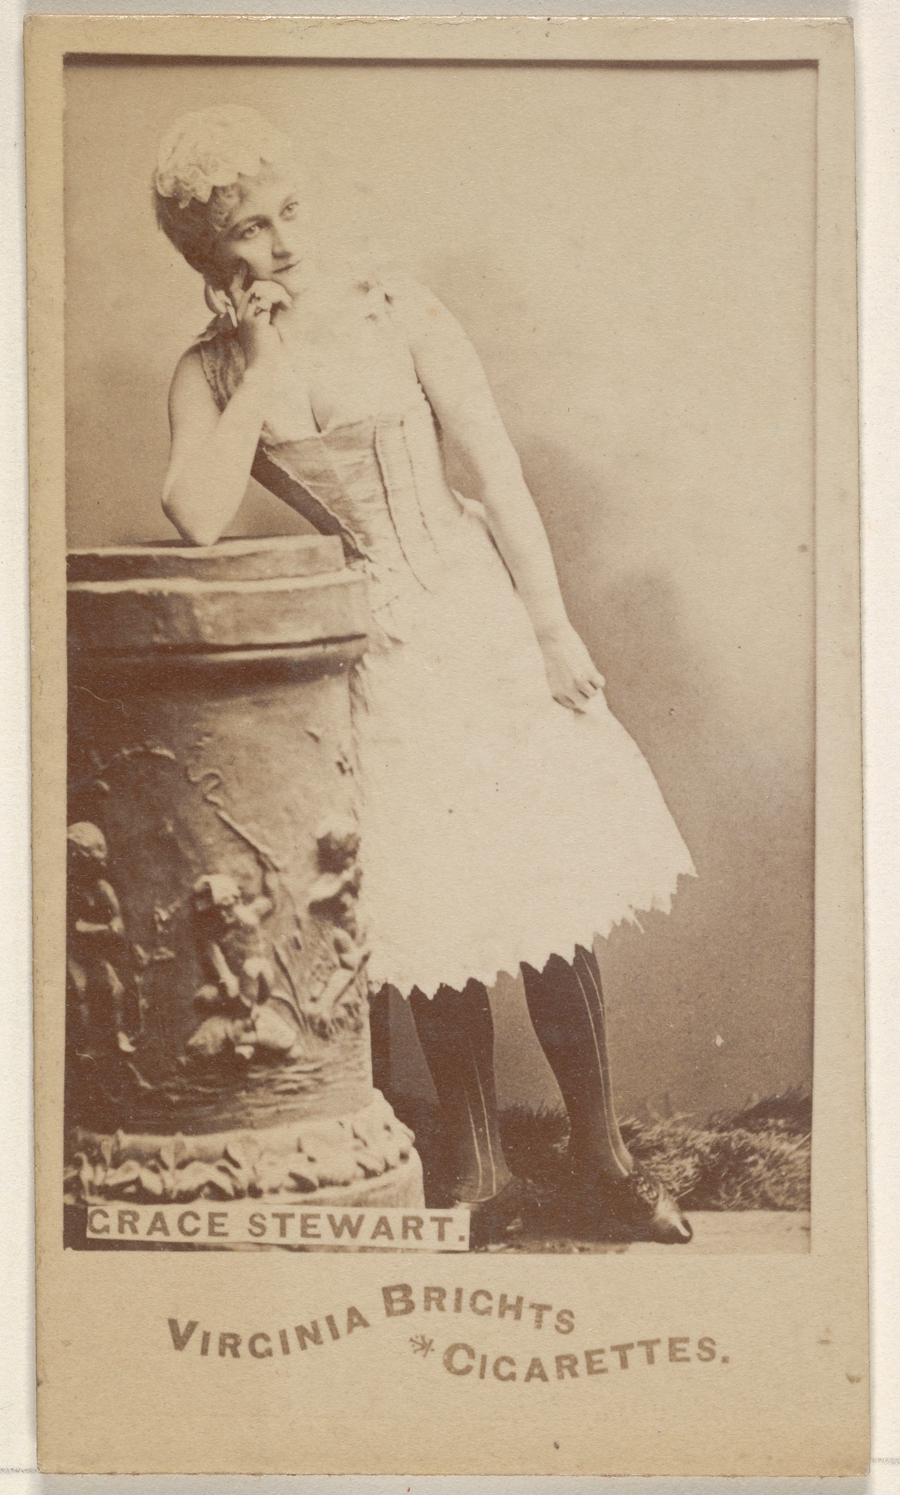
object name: photograph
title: Grace Stewart, from the Actors and Actresses series (N45, Type 6) for Virginia Brights Cigarettes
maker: allen & ginter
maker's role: publisher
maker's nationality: american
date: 1888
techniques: albumen silver print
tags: portraits,women,actresses